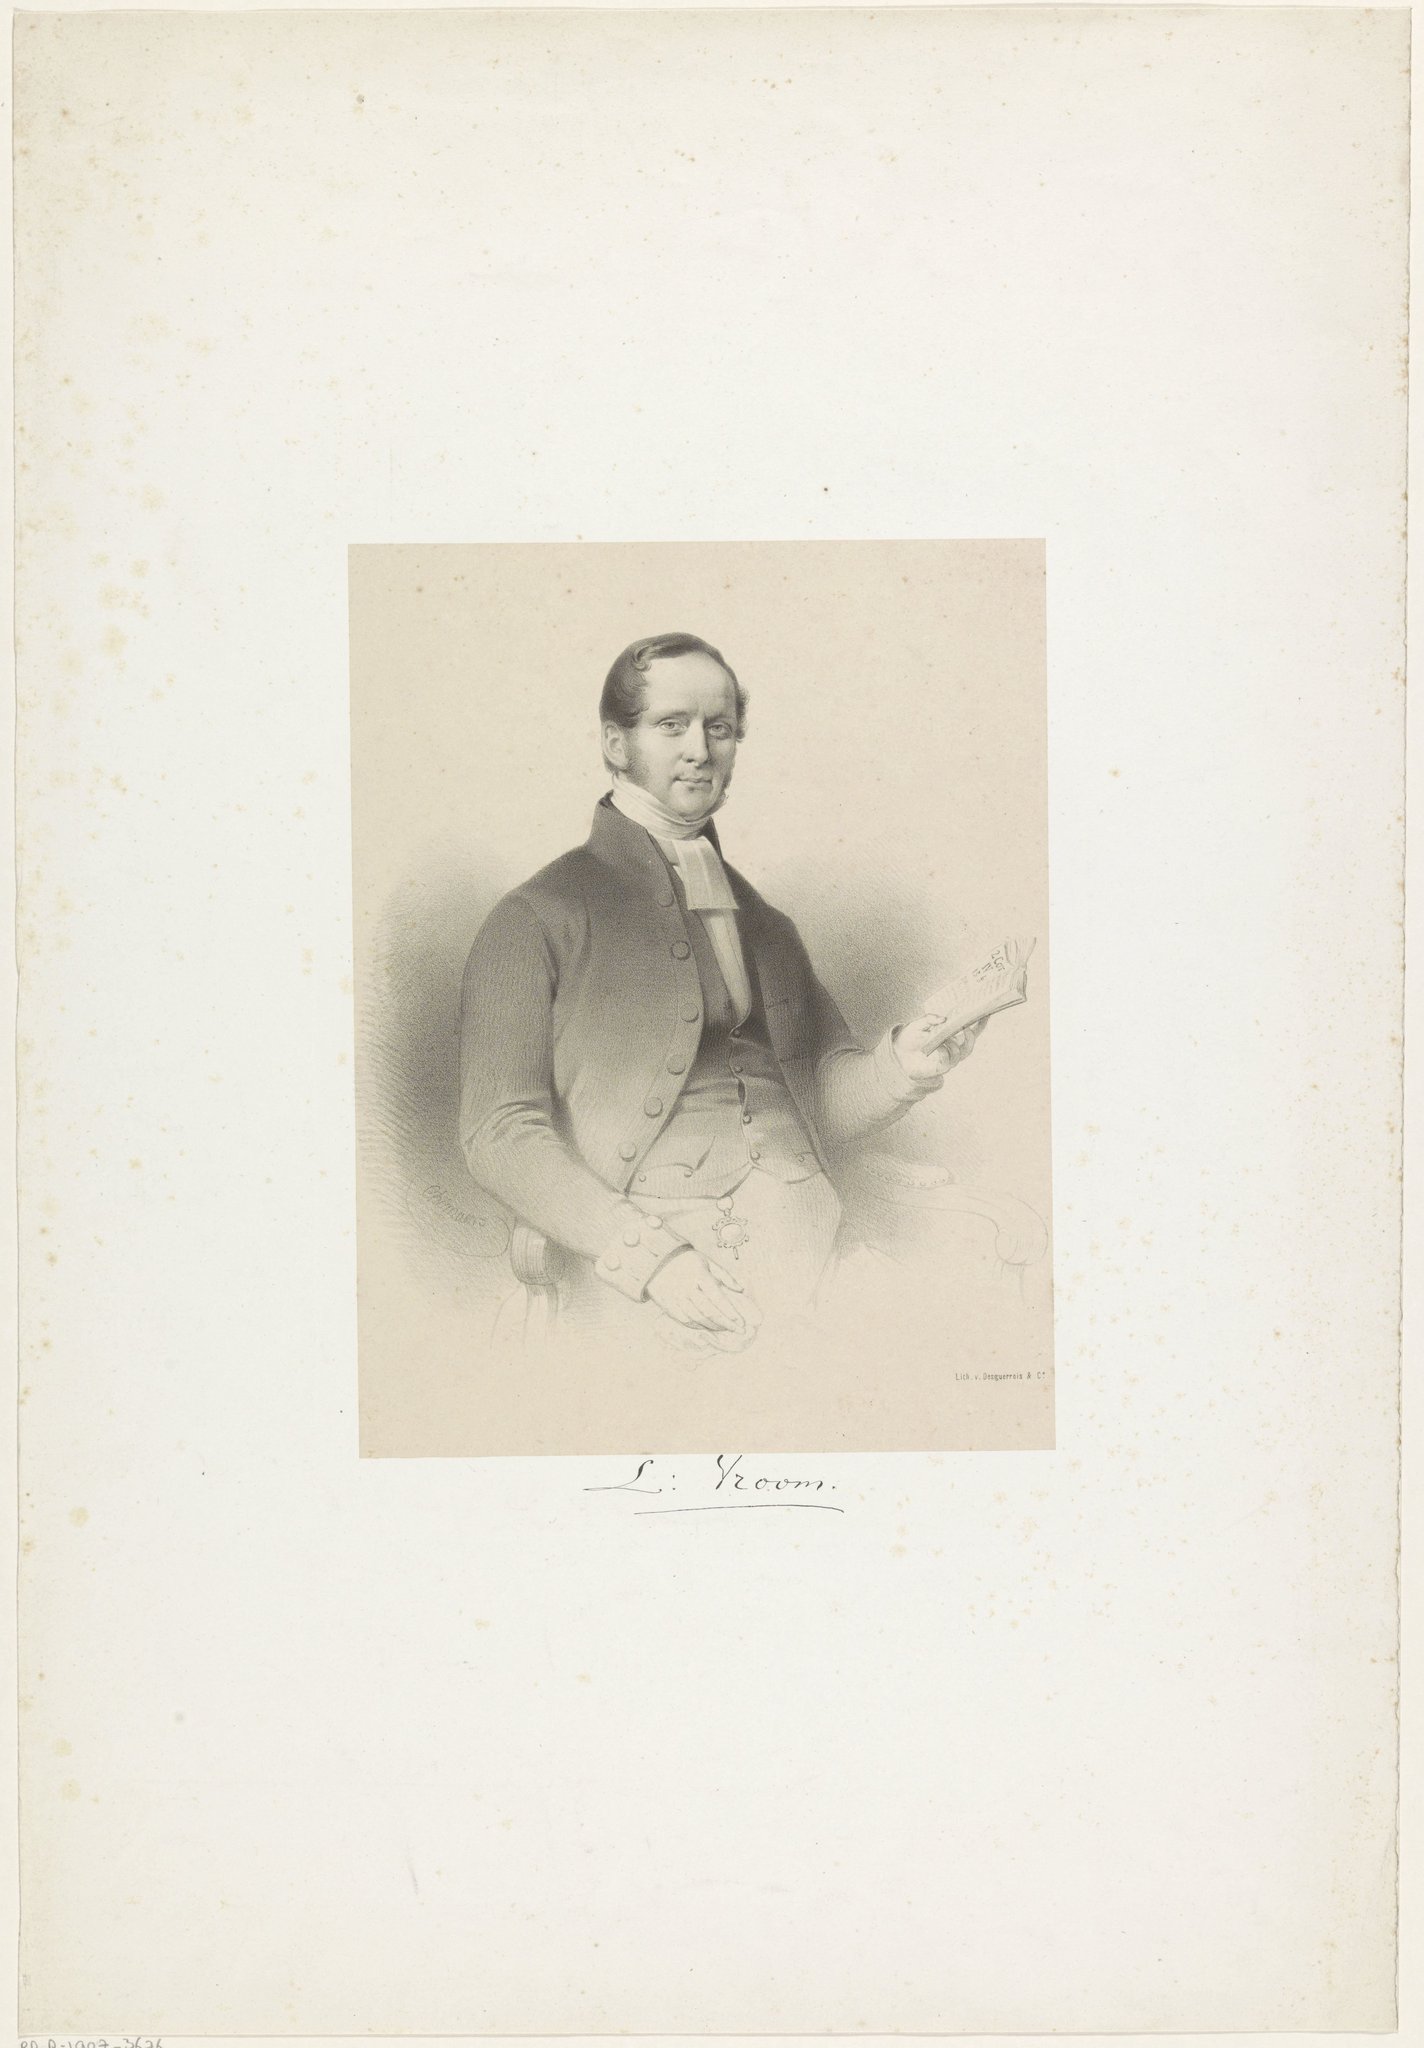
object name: print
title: Portret van L. Vroom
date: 1832-1873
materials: paper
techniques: lithograph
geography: amsterdam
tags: handkerchief, historical persons (+ (full) bust portrait), the bible as a book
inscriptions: collector's mark: Lugt 2228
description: De geportretteerde heeft een opengeslagen bijbel in zijn linkerhand, in zijn rechterhand heeft hij een zakdoek. Hij draagt een bef en, onderaan zijn vest, een klein rond sieraad, vergrootglas of zakhorloge. Onder het portret de signatuur van de geportretteerde.